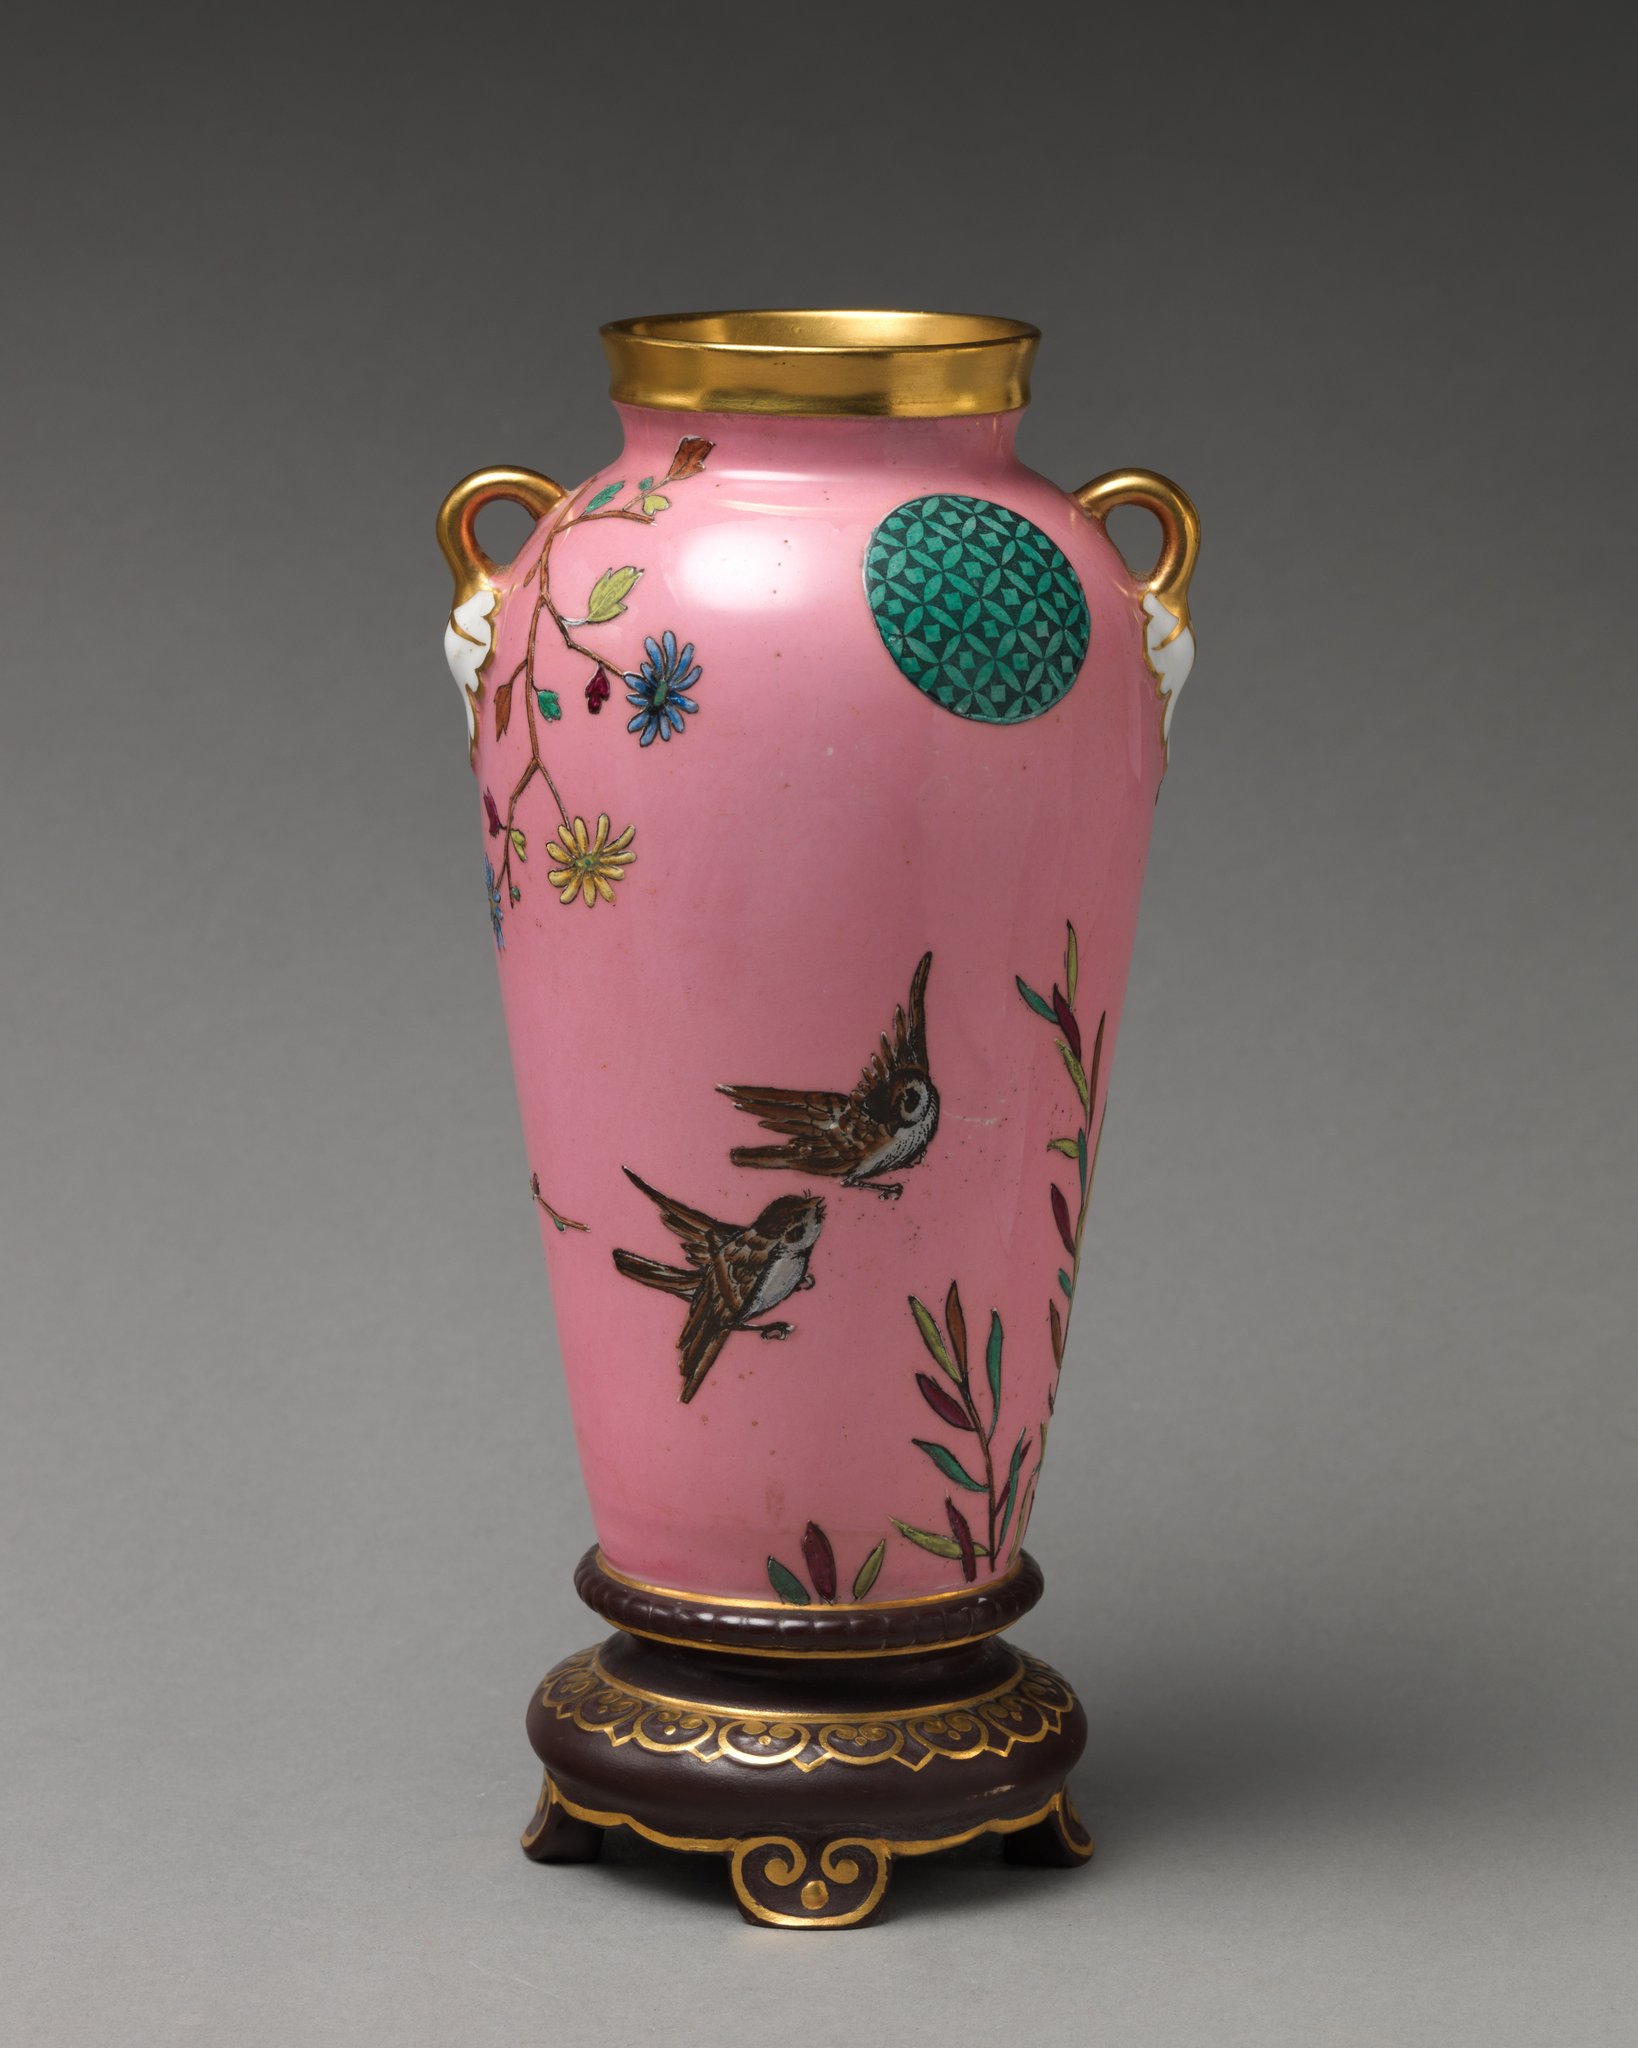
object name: vase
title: Vase with flowering branch motif (one of a pair)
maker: minton(s)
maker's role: maker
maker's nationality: british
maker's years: 1793-2001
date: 1872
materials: bone china